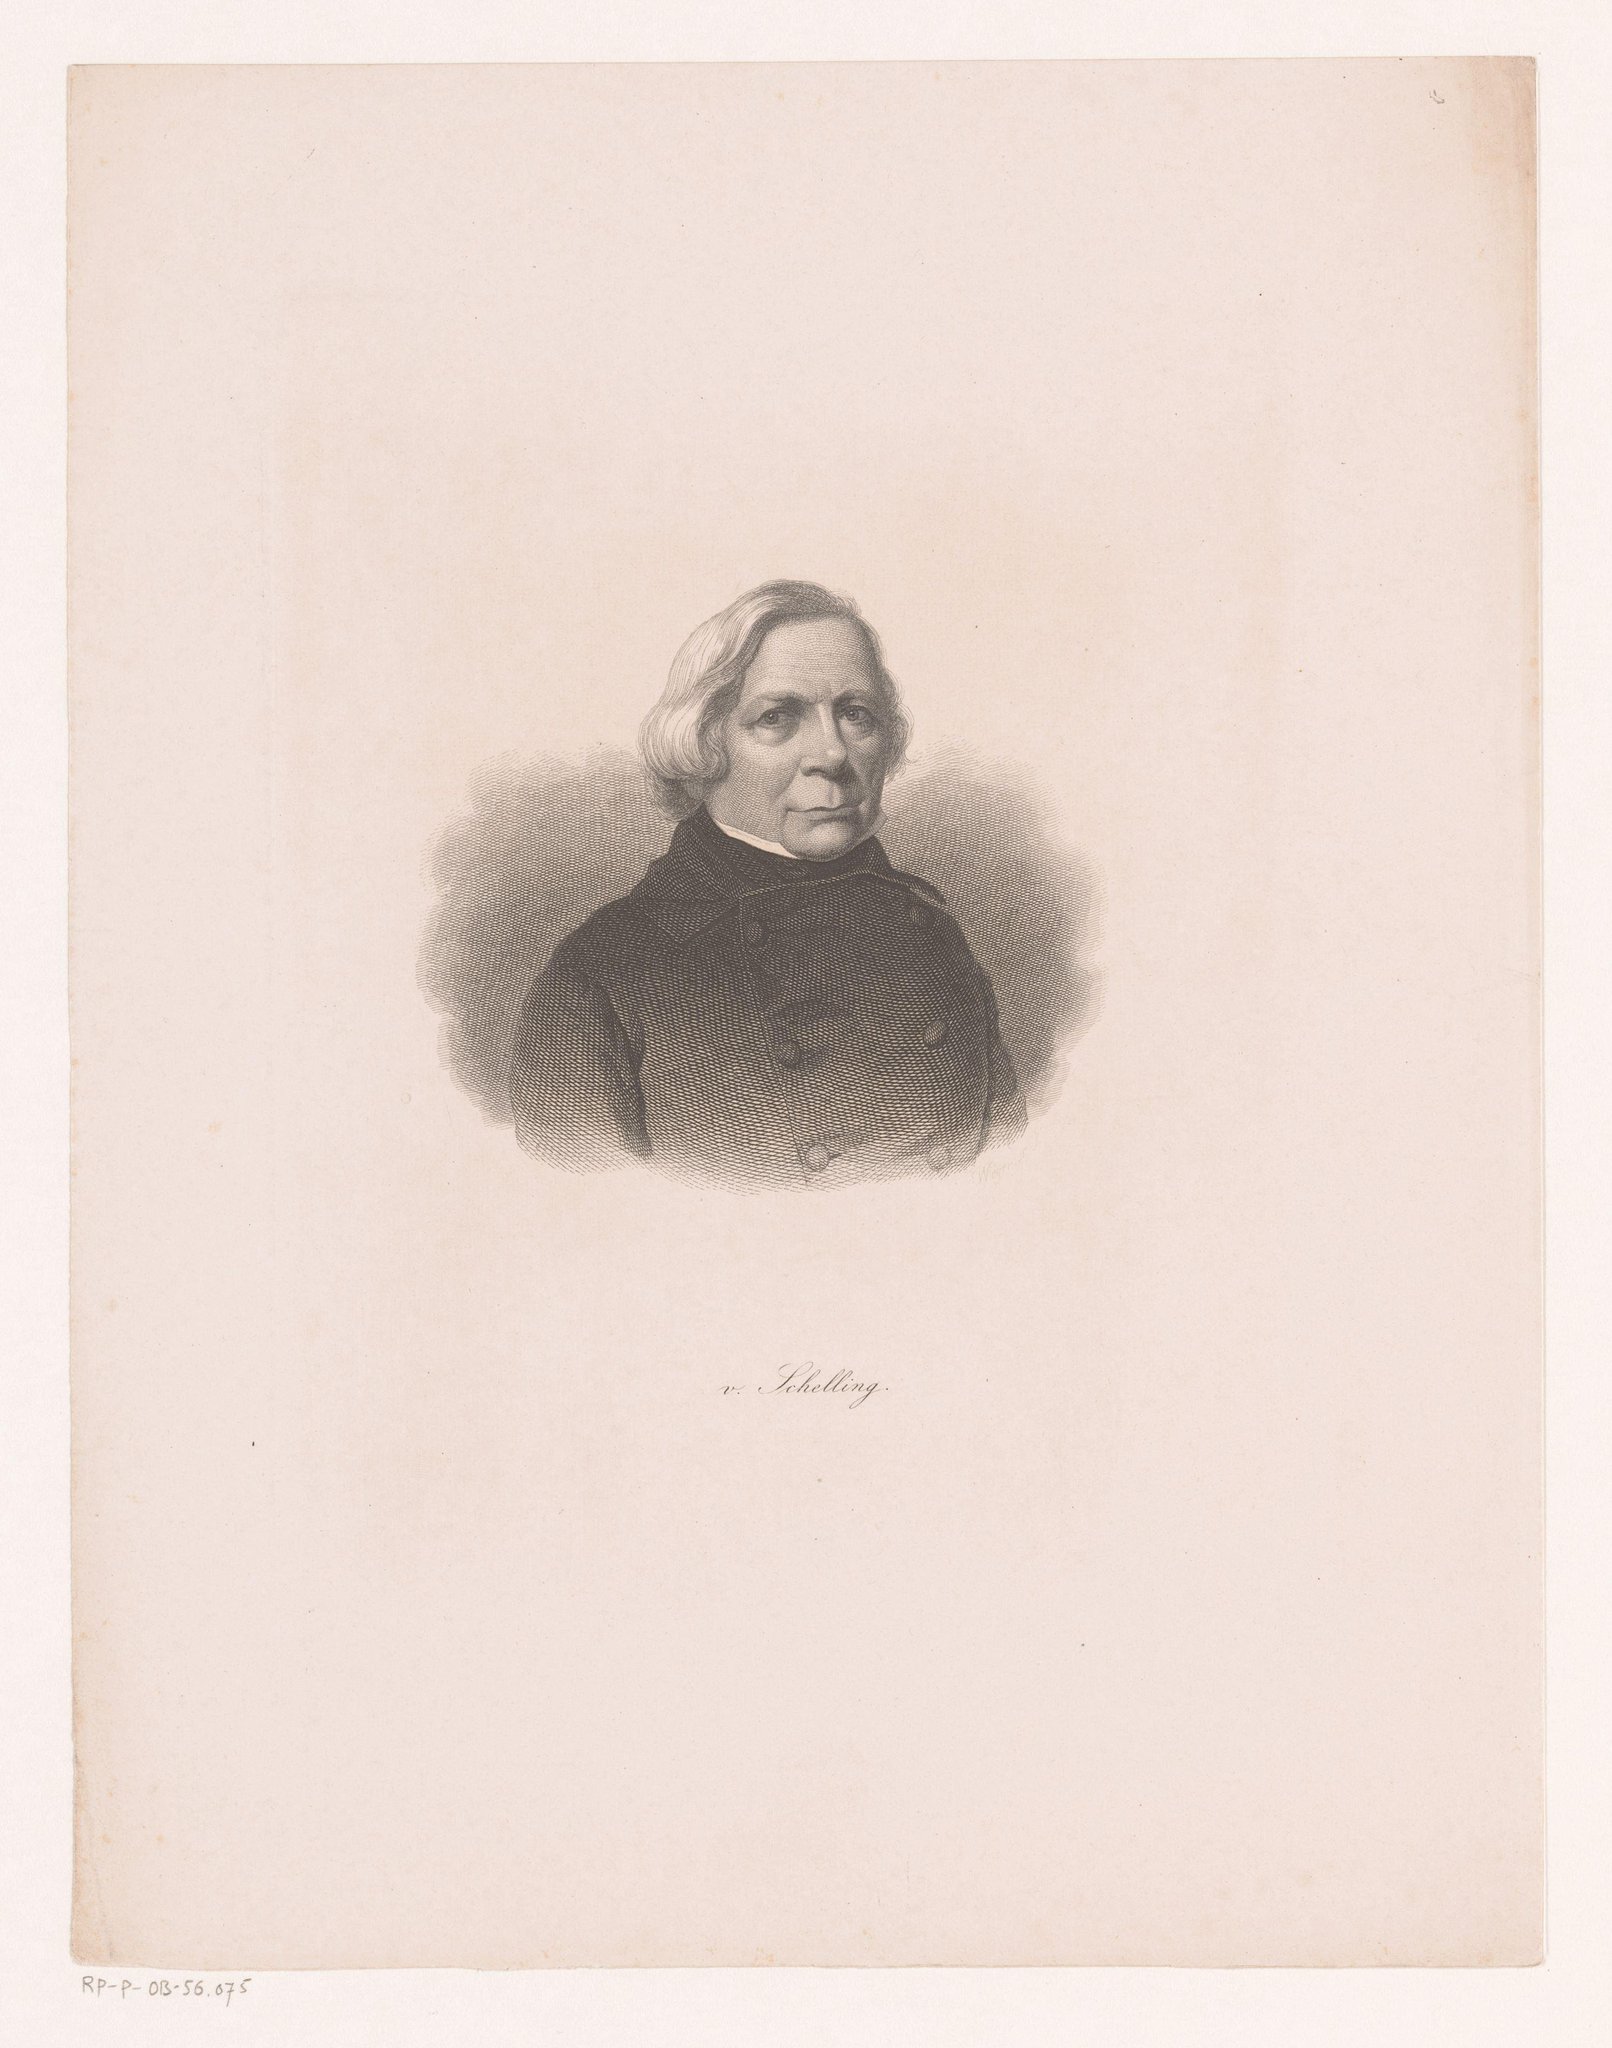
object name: print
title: Portret van Friedrich von Schelling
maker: august weger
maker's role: print maker, printer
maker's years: 1823-1892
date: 1849-1892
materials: paper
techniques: engraving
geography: leipzig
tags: historical persons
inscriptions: collector's mark: Lugt 2228